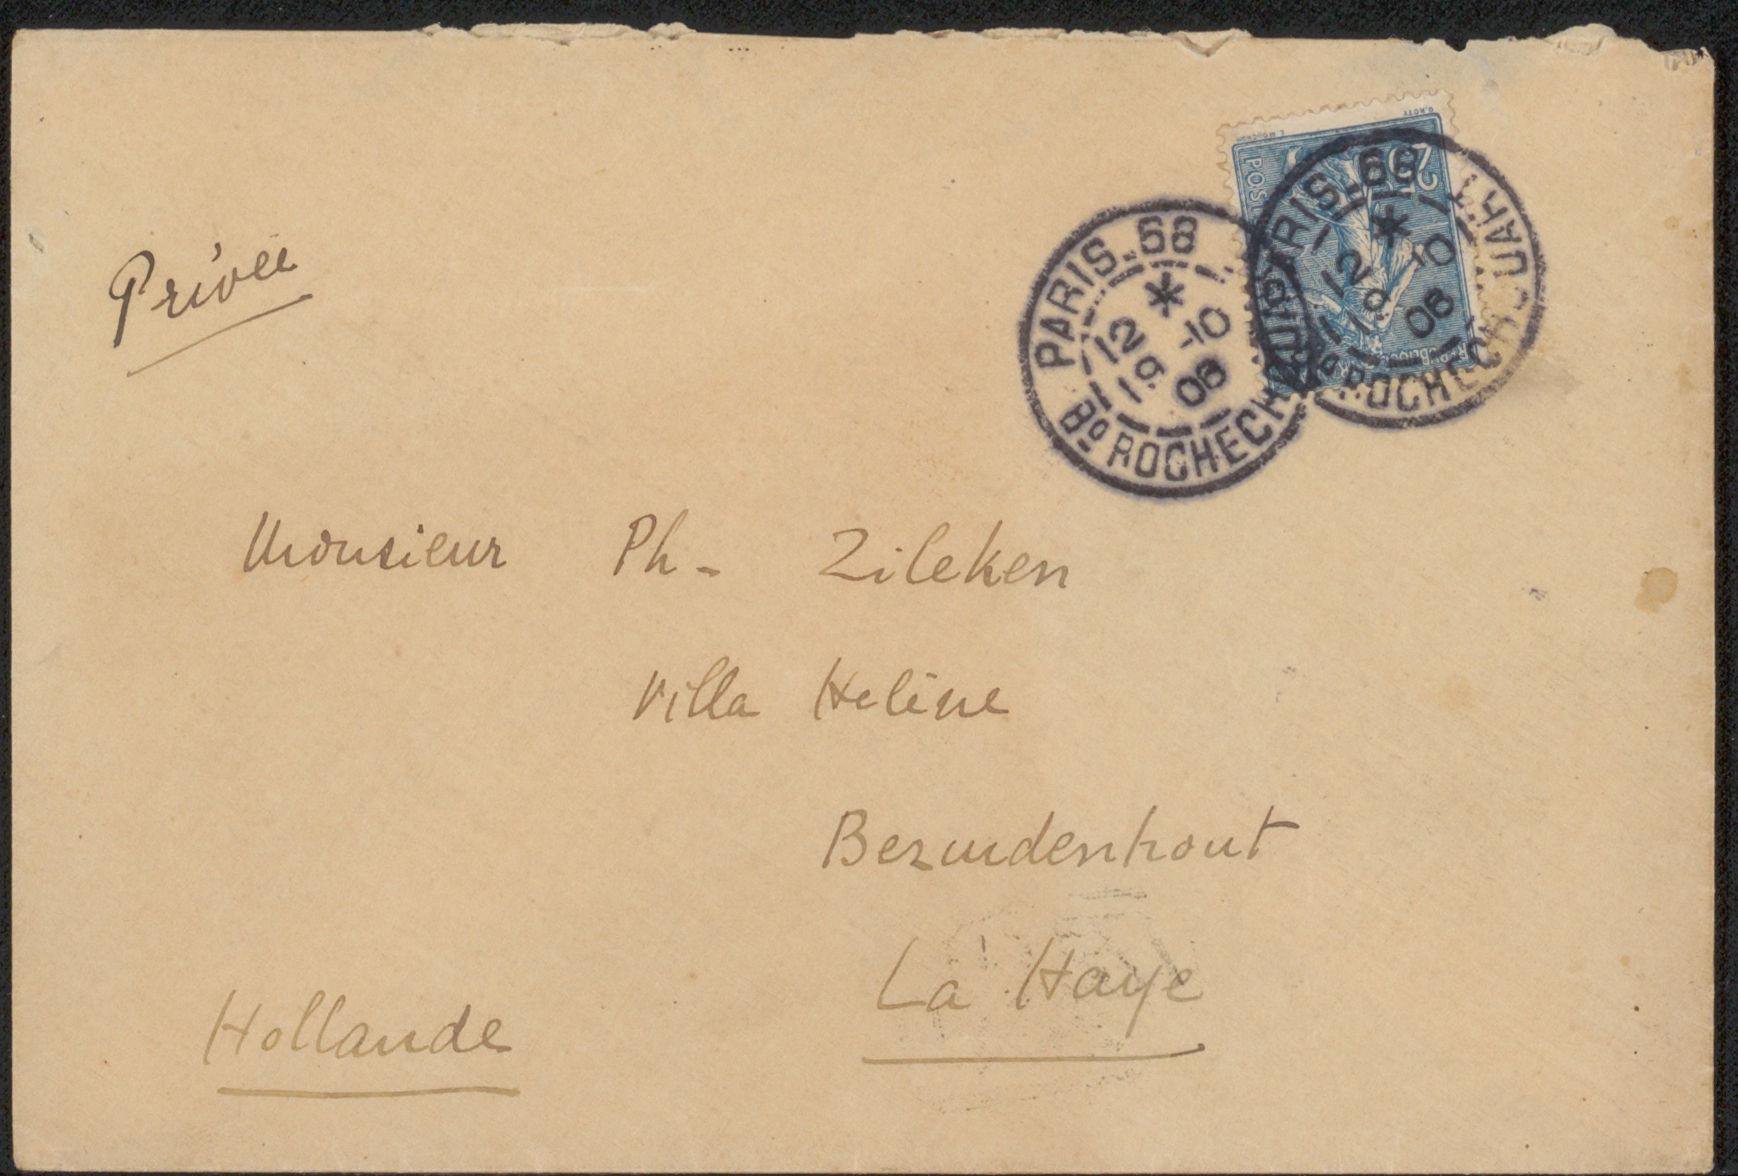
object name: envelope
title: Envelop aan Philip Zilcken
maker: lugné-poe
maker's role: acteur, theaterdirecteur, theatervormgever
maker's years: 1869-1940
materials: ink, paper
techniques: pen, writing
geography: paris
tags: the hague, painter, draughtsman, philip zilcken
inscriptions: collector's mark: ‘RPK’